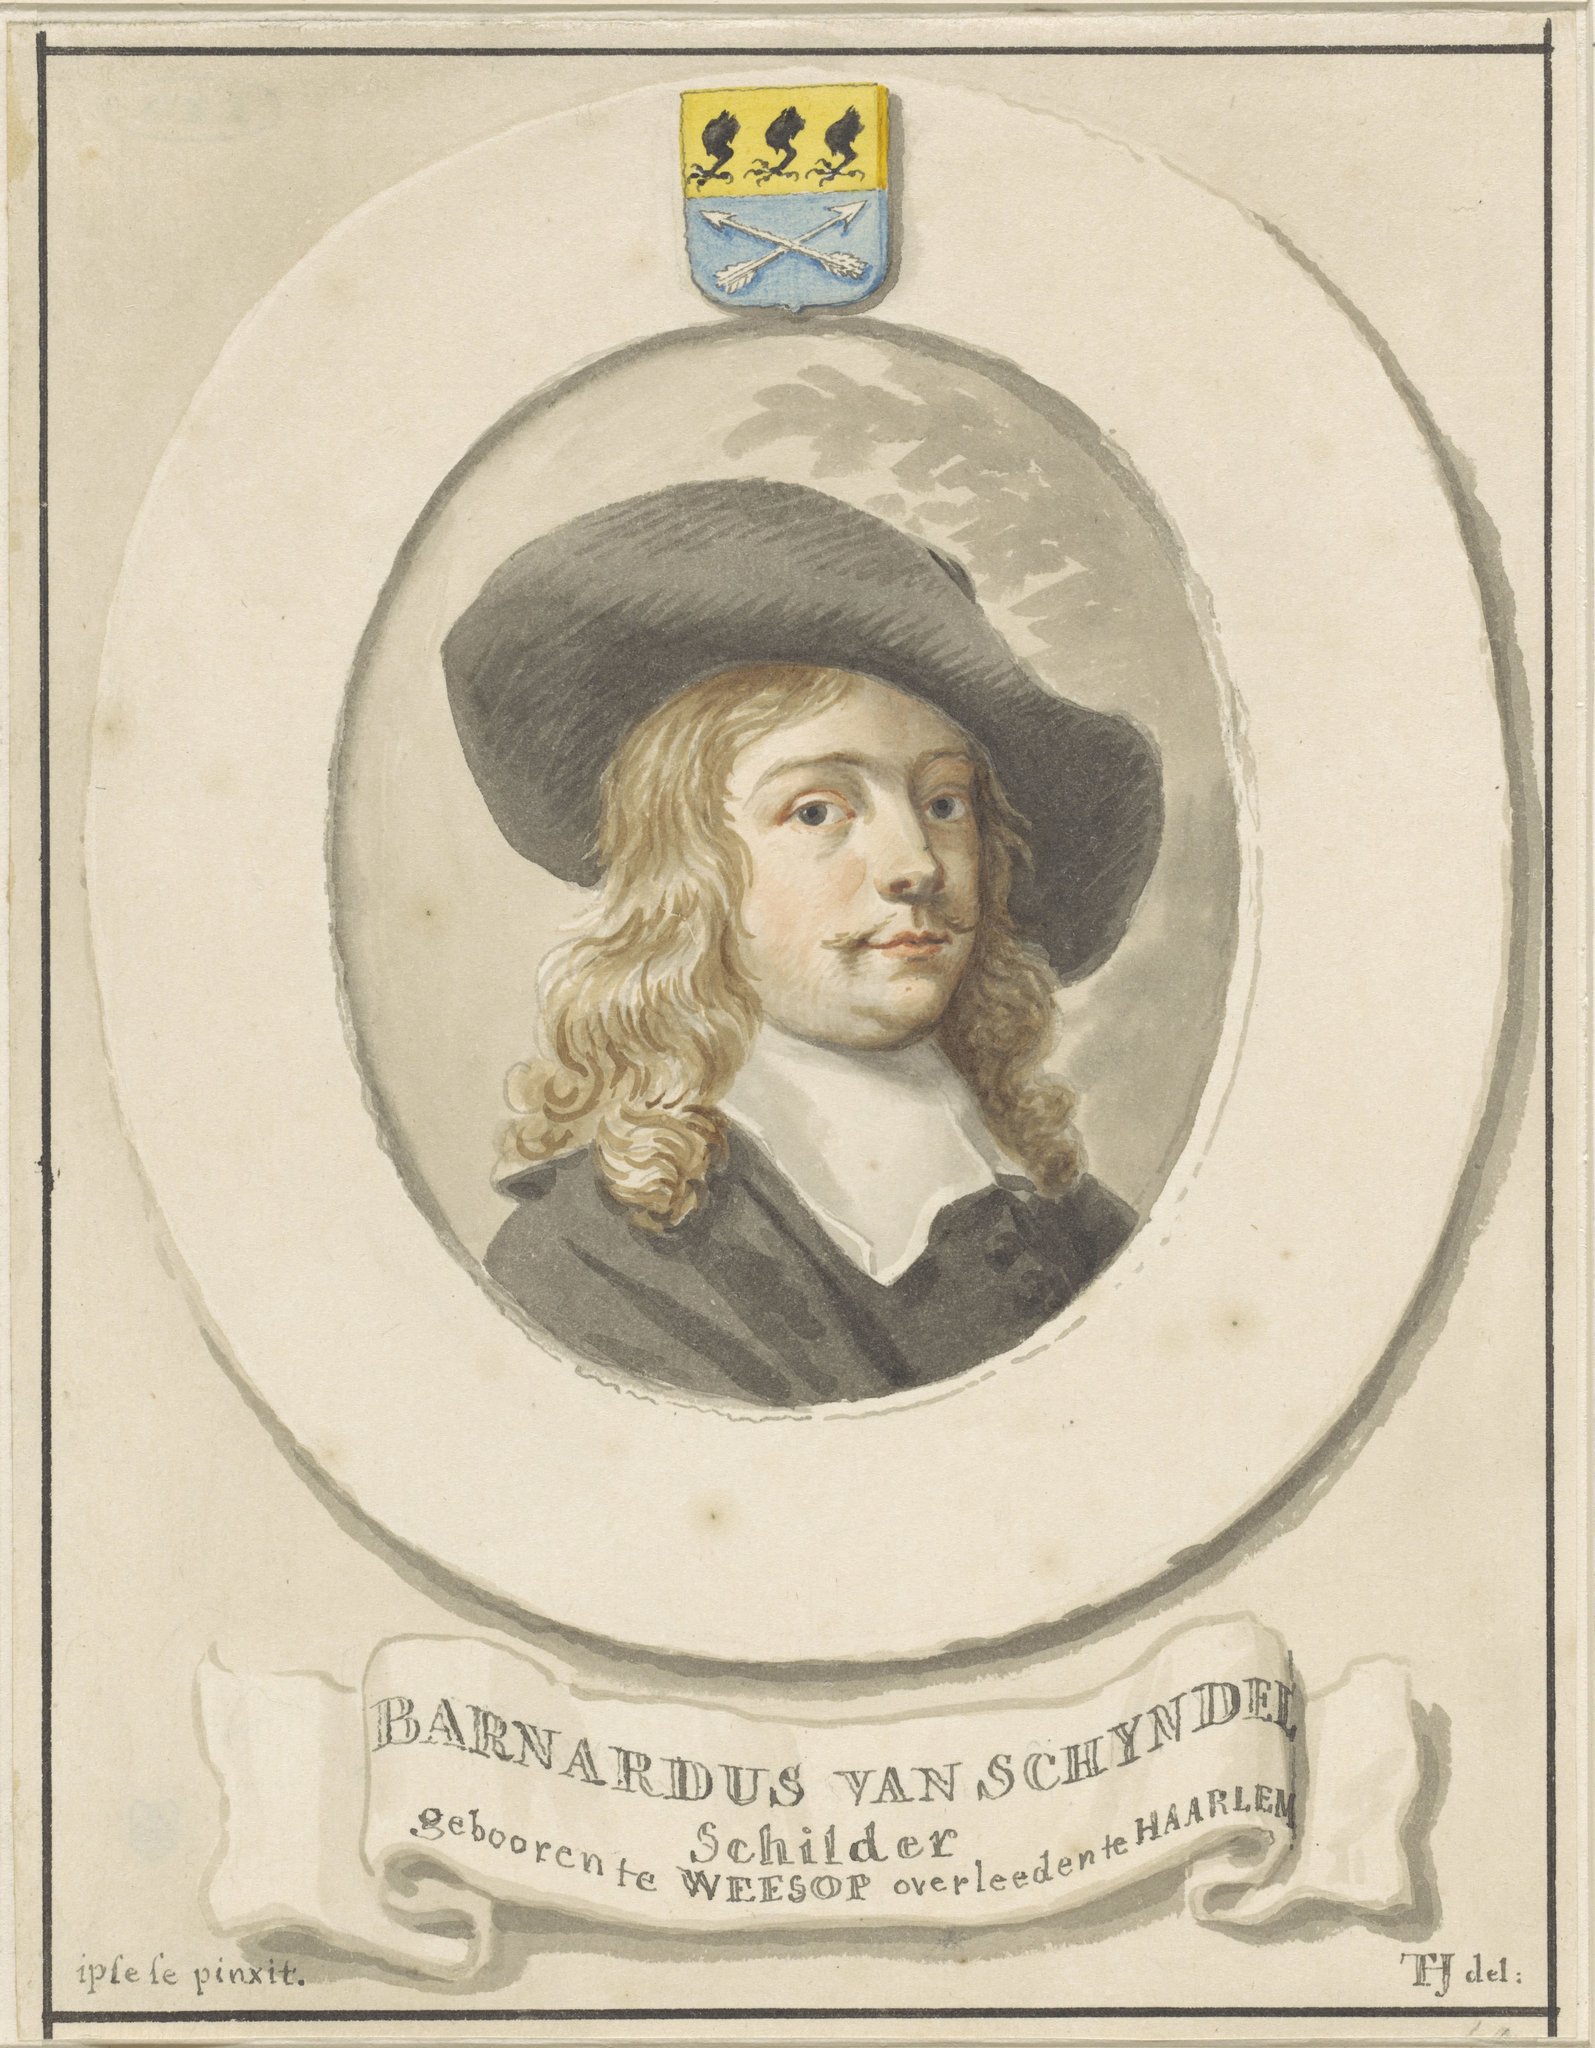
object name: drawing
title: Portret van Bernardus van Schendel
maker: tako hajo jelgersma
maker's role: draughtsman, painter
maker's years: 1702-1795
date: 1712-1795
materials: paper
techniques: brush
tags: bernardus van schijndel, historical persons, portrait, self-portrait of painter, portrait, self-portrait of artist